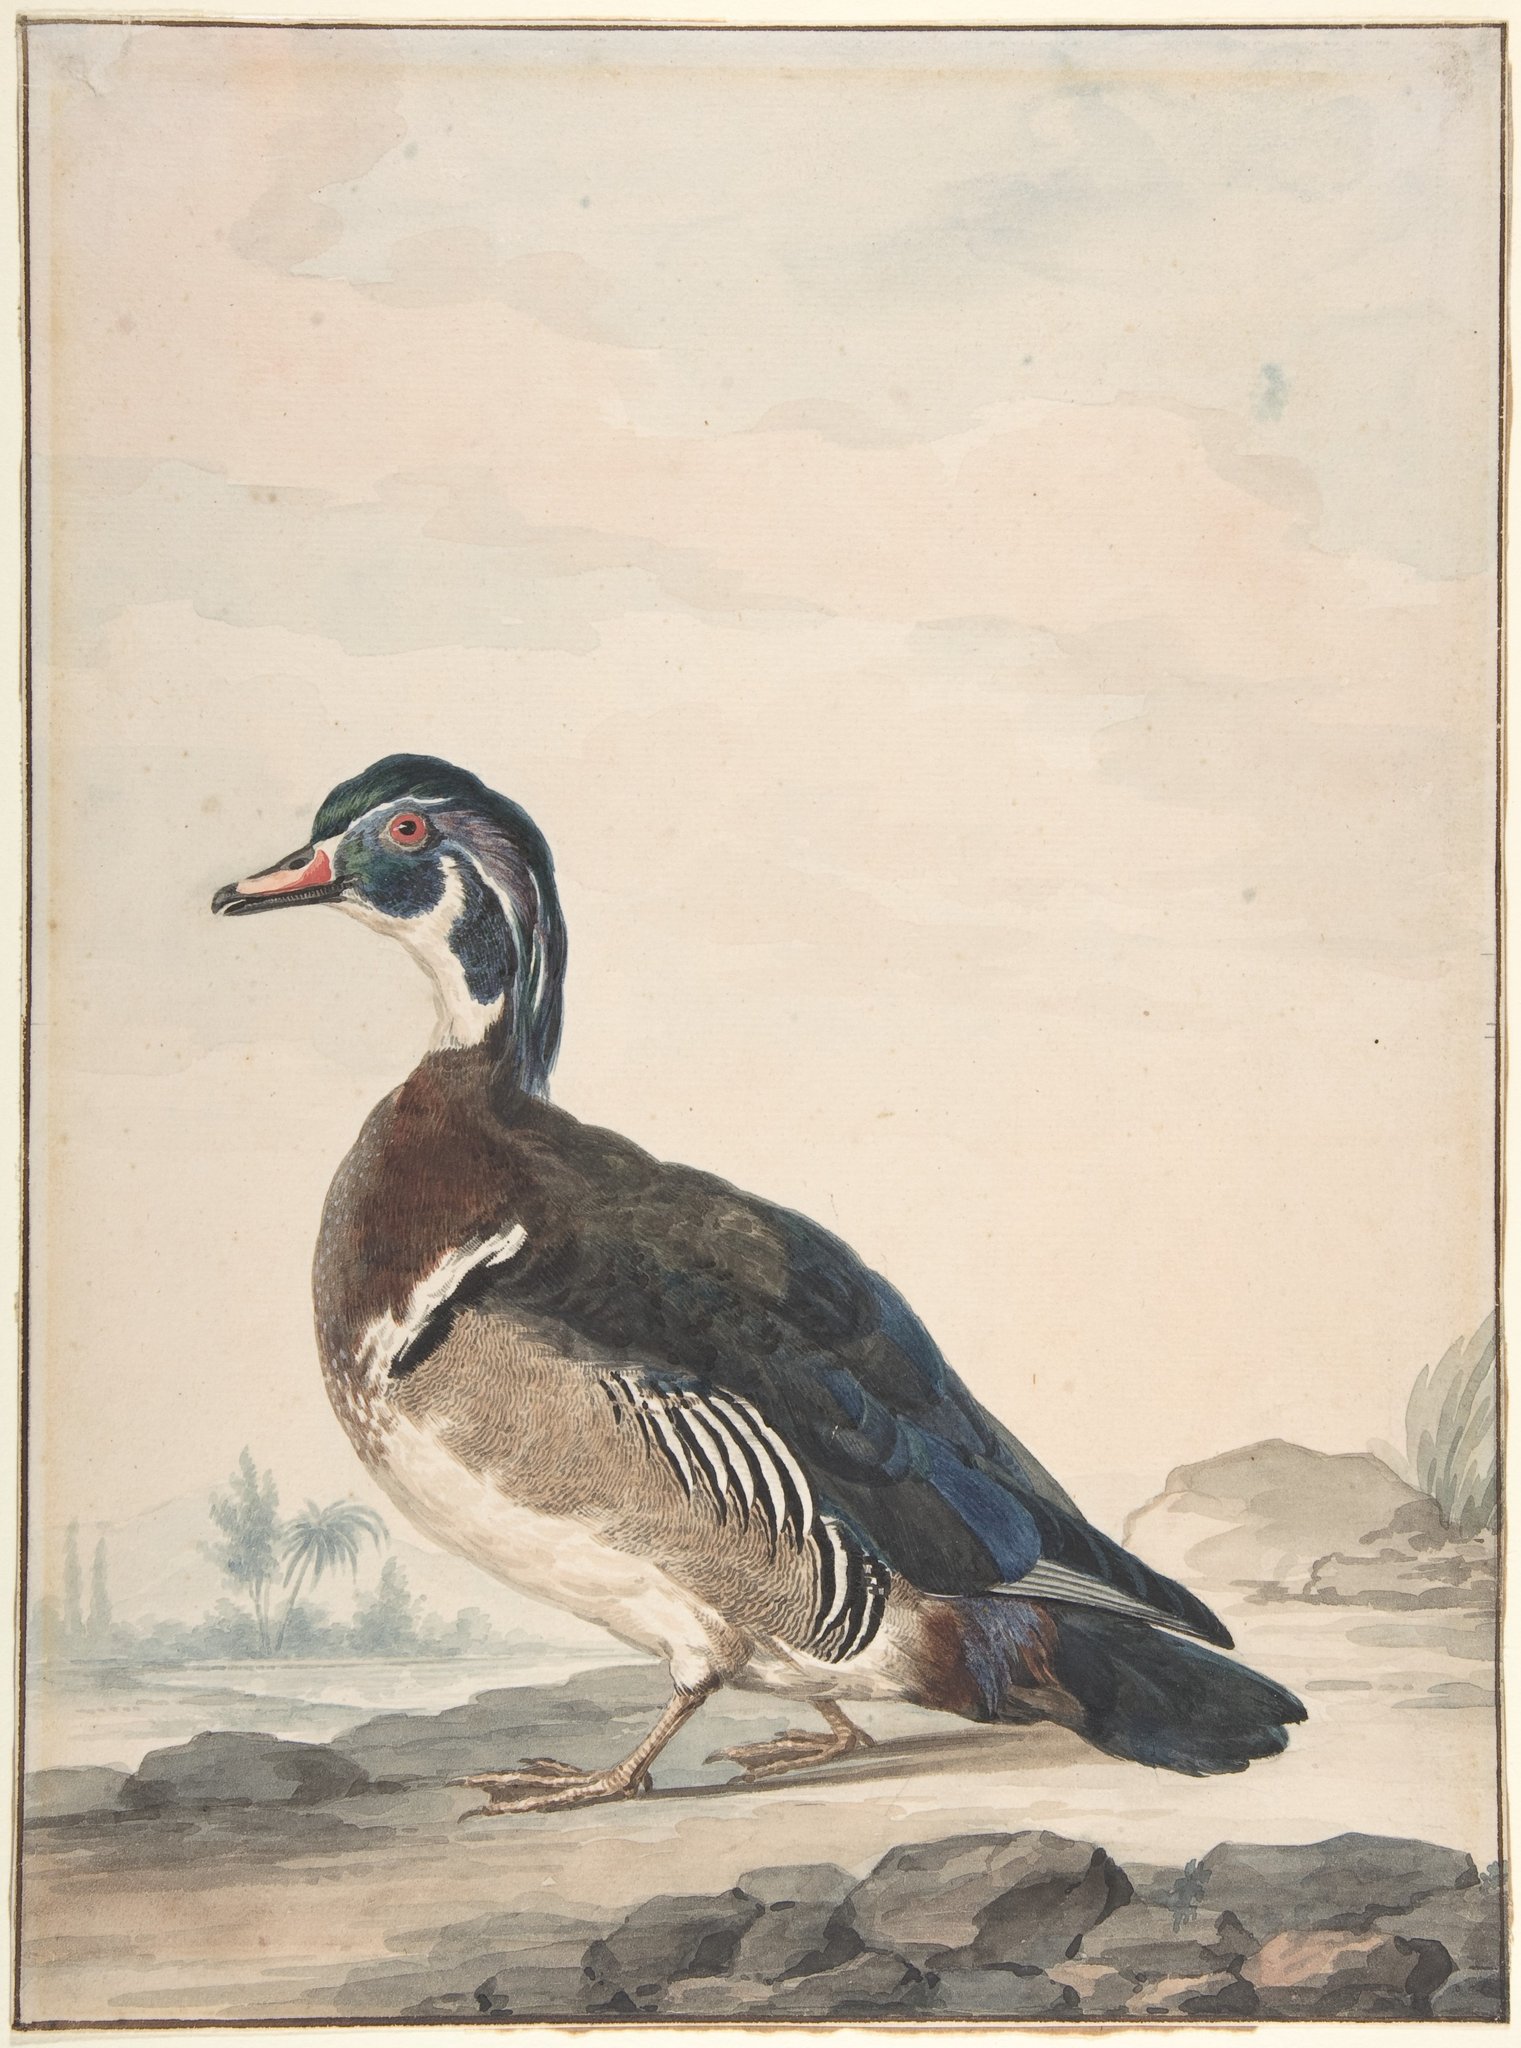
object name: drawing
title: A Duck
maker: aert schouman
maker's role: artist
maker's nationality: netherlandish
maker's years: 1710-1792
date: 1634-1700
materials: gouache, watercolor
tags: ducks